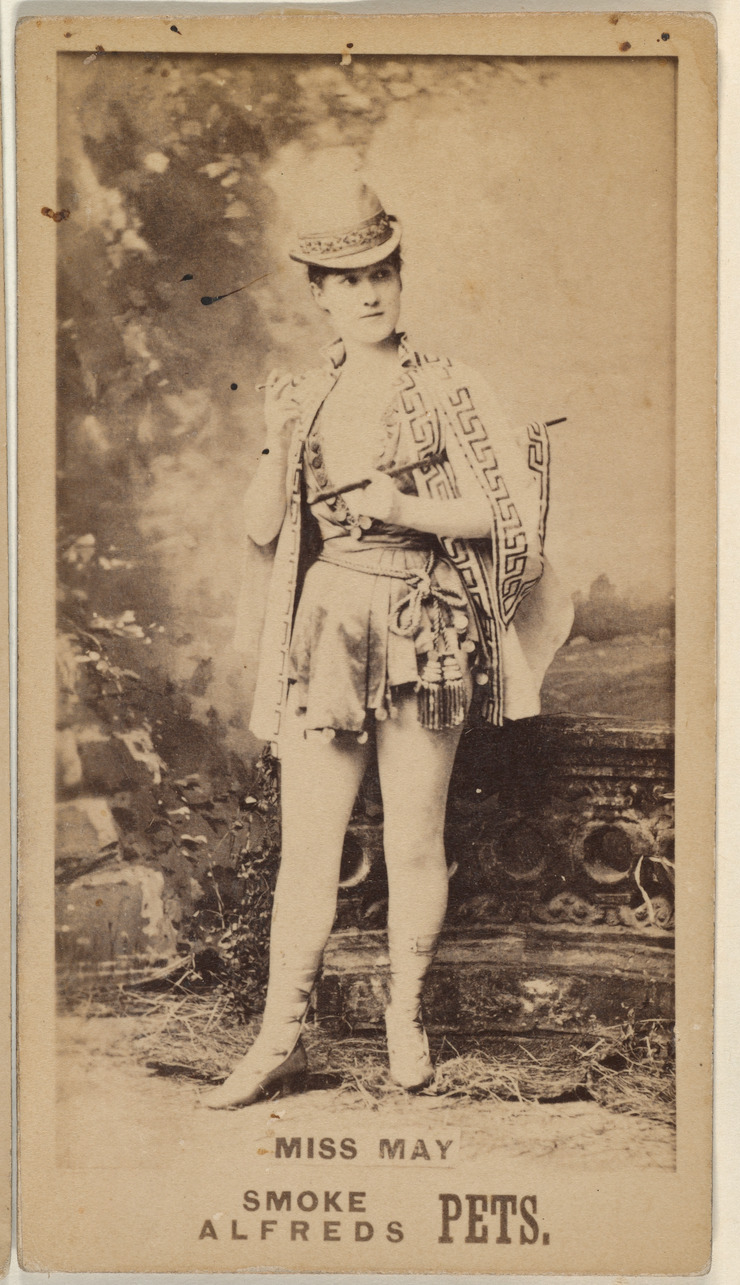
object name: photograph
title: Miss May, from the Actresses series (N671), promoting Alfreds Pets Tobacco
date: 1888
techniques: albumen silver print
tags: portraits,women,actresses